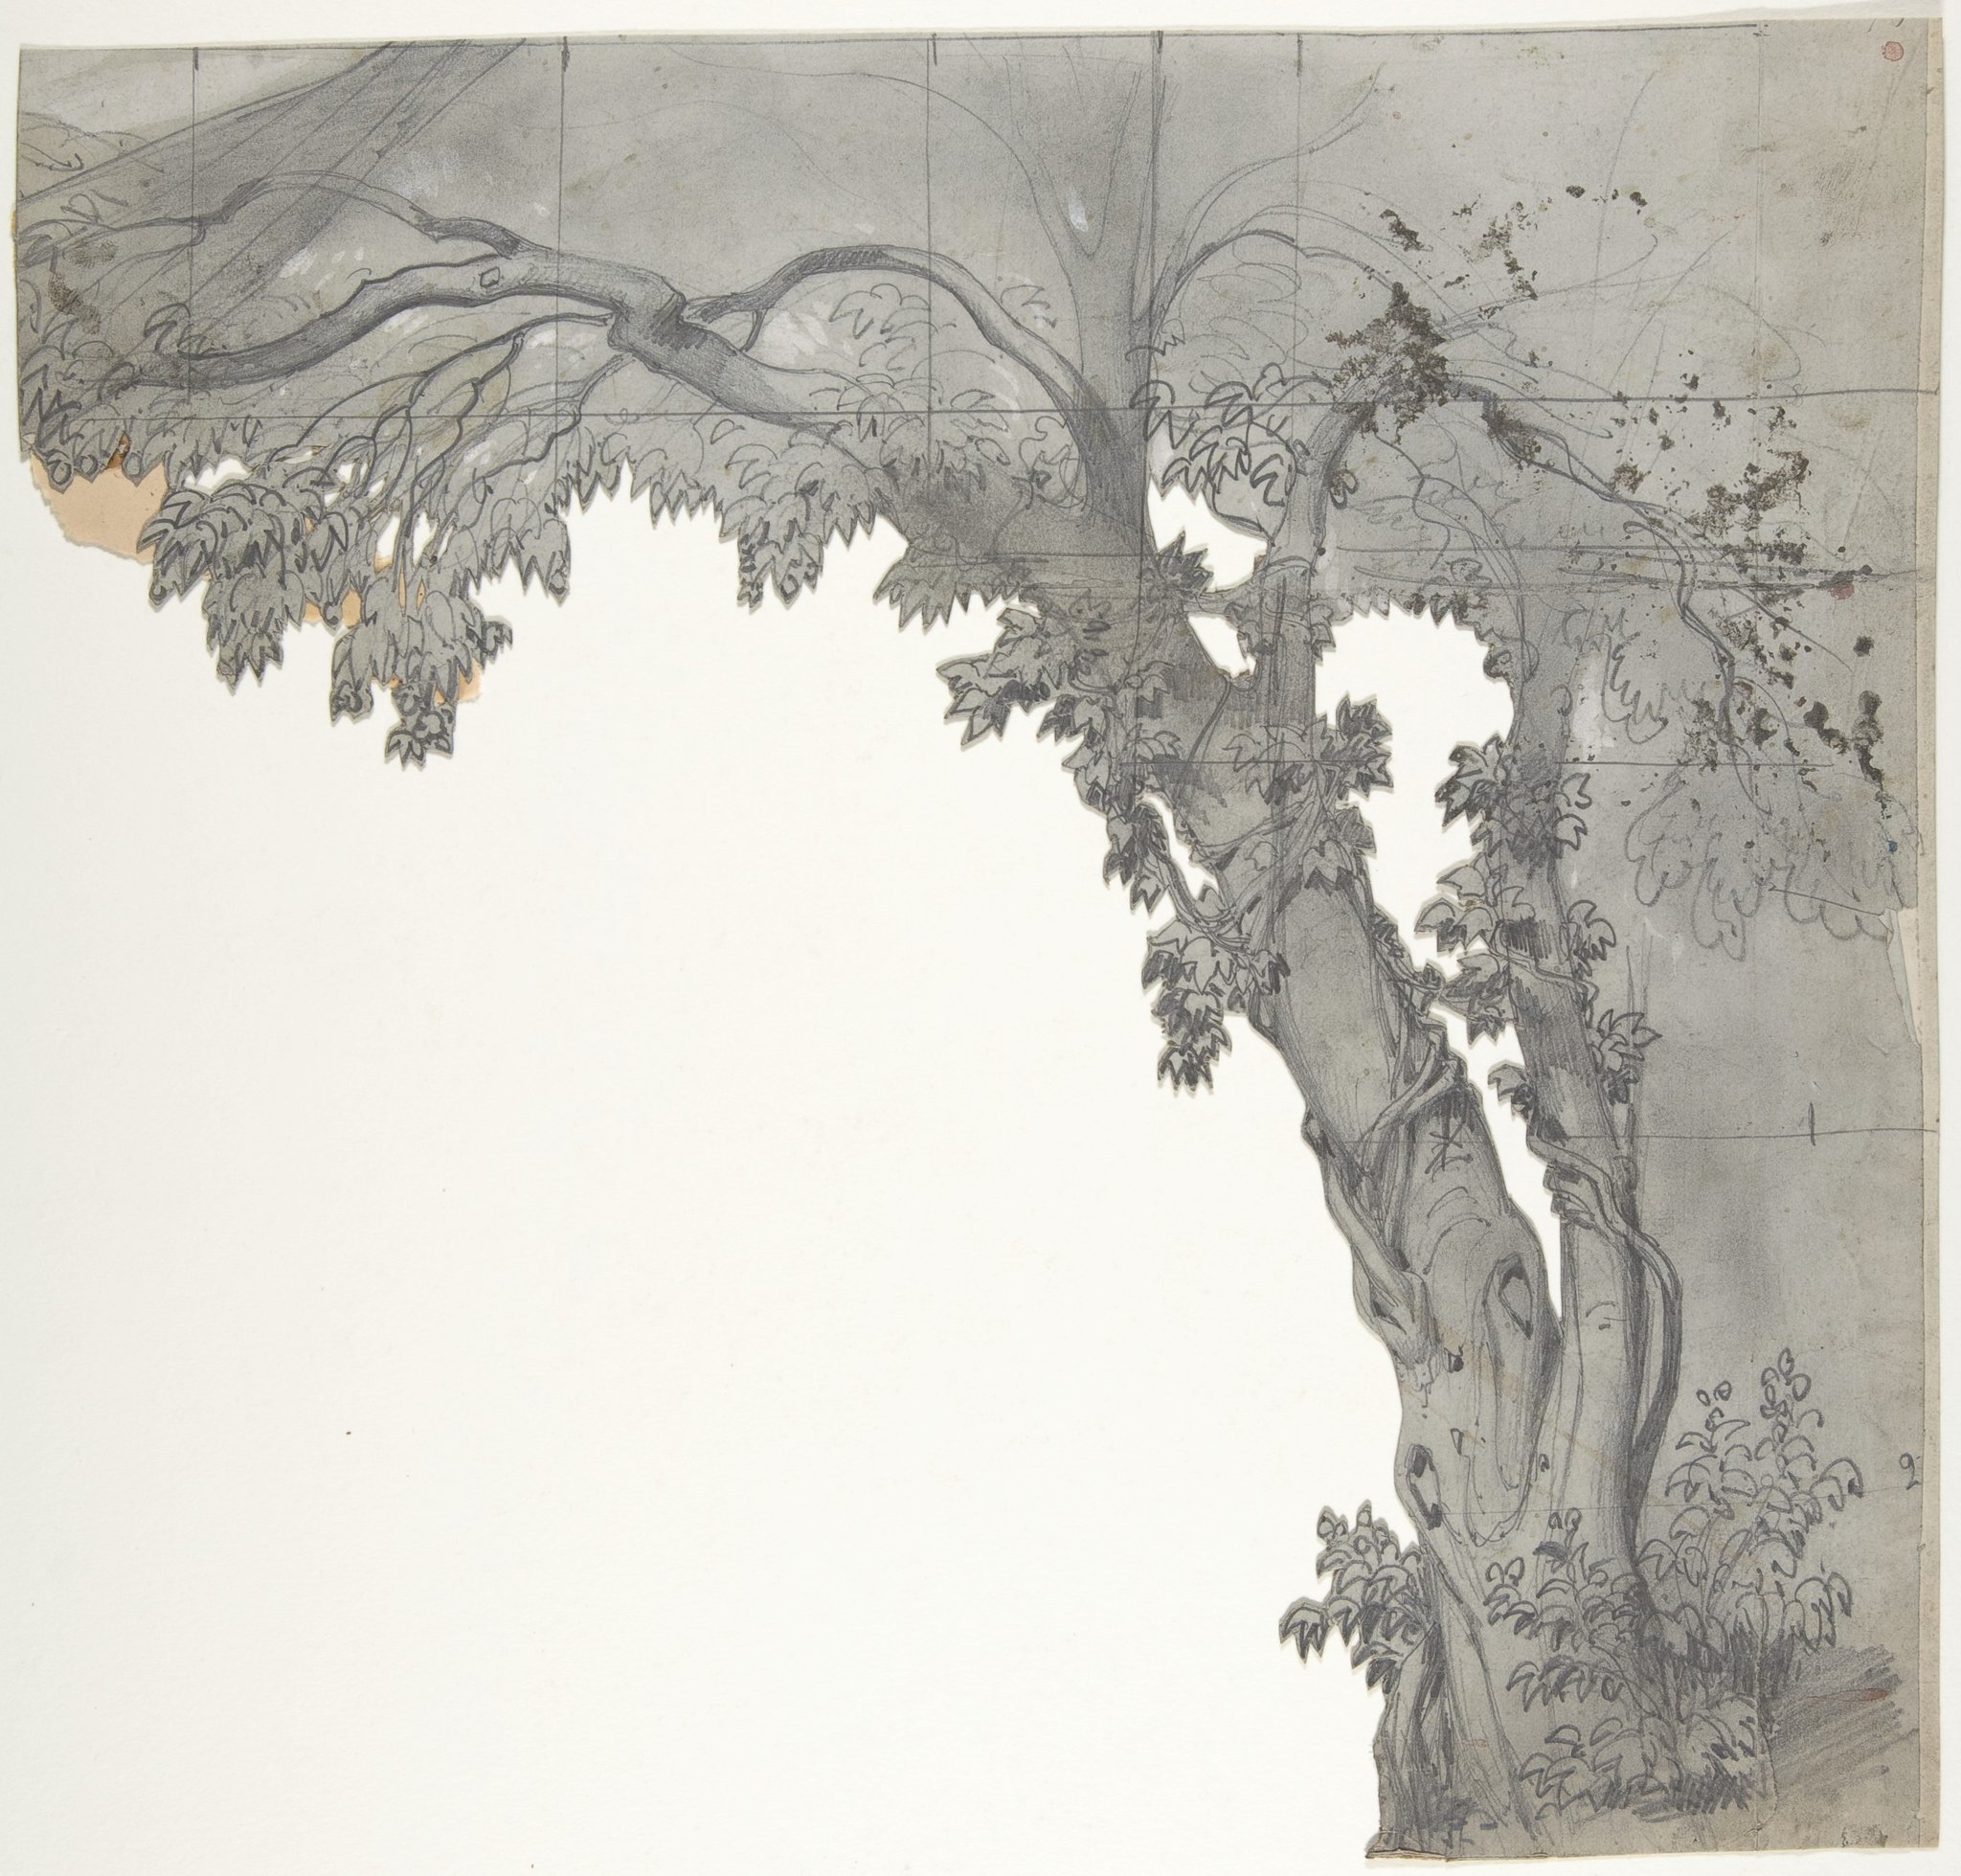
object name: drawing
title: Design for a Stage Set at the Opéra, Paris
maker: eugène cicéri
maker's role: artist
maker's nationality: french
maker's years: 1813-1890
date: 1830-1890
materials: graphite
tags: trees,stage design